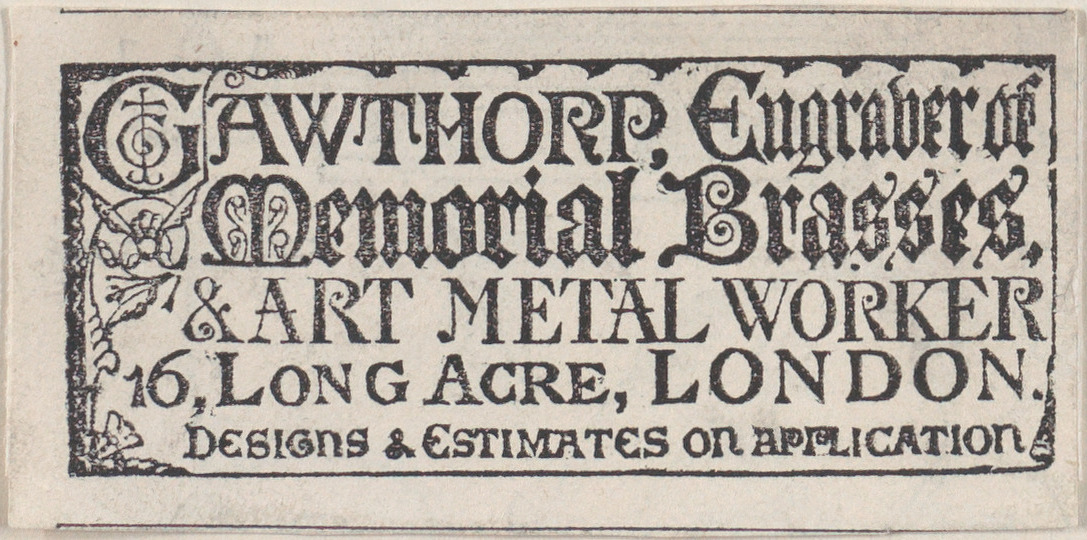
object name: print, trade card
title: Trade card for Gawthorp, Engraver and Art Metal worker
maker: anonymous, british, 19th century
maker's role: artist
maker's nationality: british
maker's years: 1800-1900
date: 1801-1900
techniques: engraving